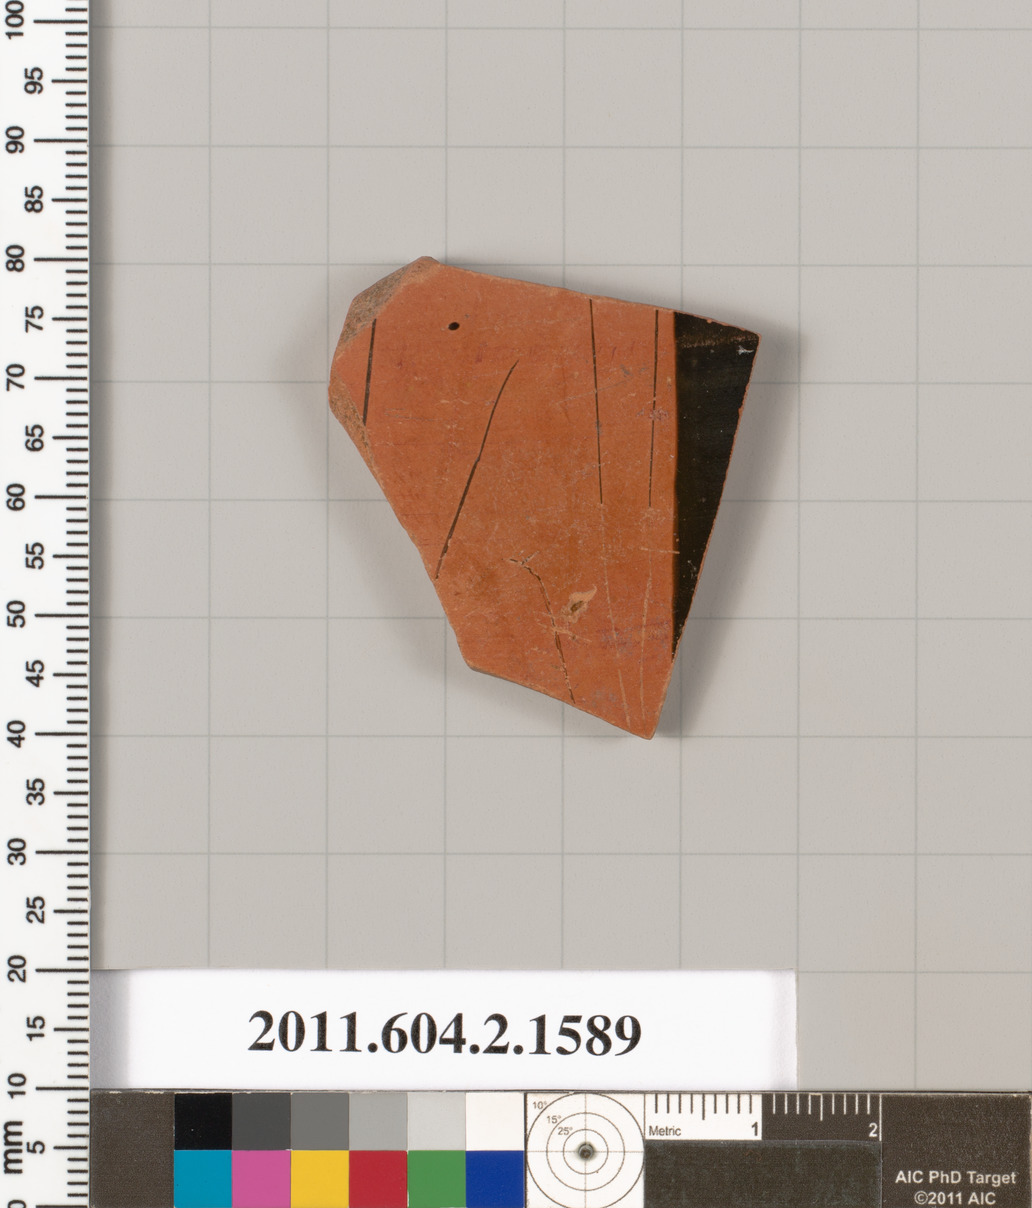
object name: skyphos fragment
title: Terracotta fragment of a skyphos (deep drinking cup)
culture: greek, attic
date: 460-440 BCE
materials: terracotta